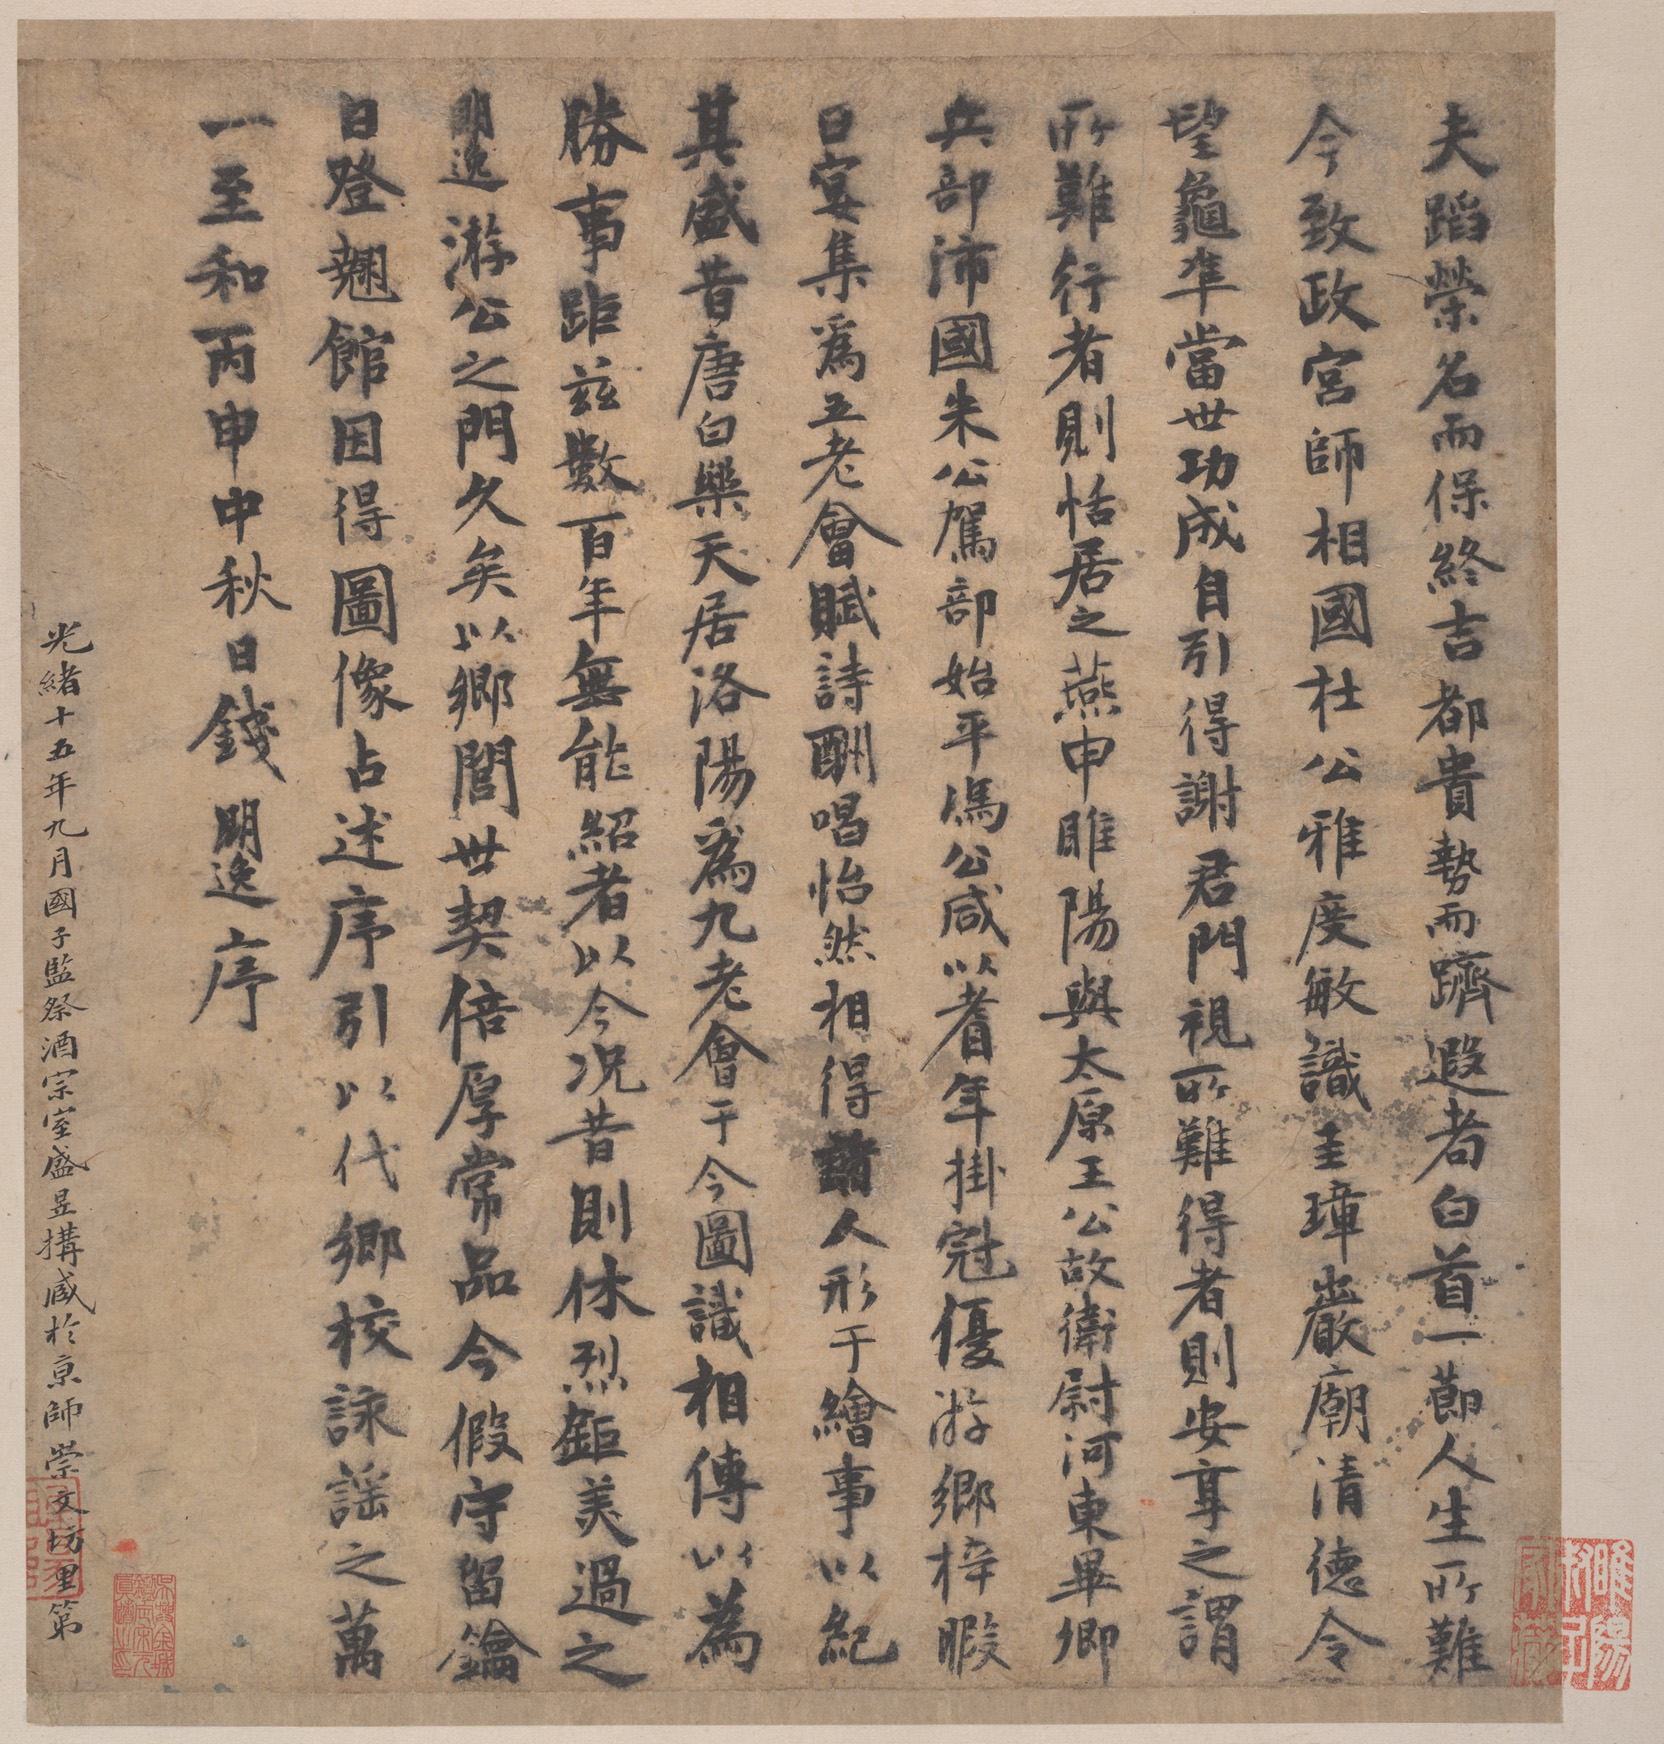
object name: album leaf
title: Frontispiece and Colophons to the Album "Five Old Men of Suiyang"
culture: chinese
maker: various scholars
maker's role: artist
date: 1000-1911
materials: ink, paper